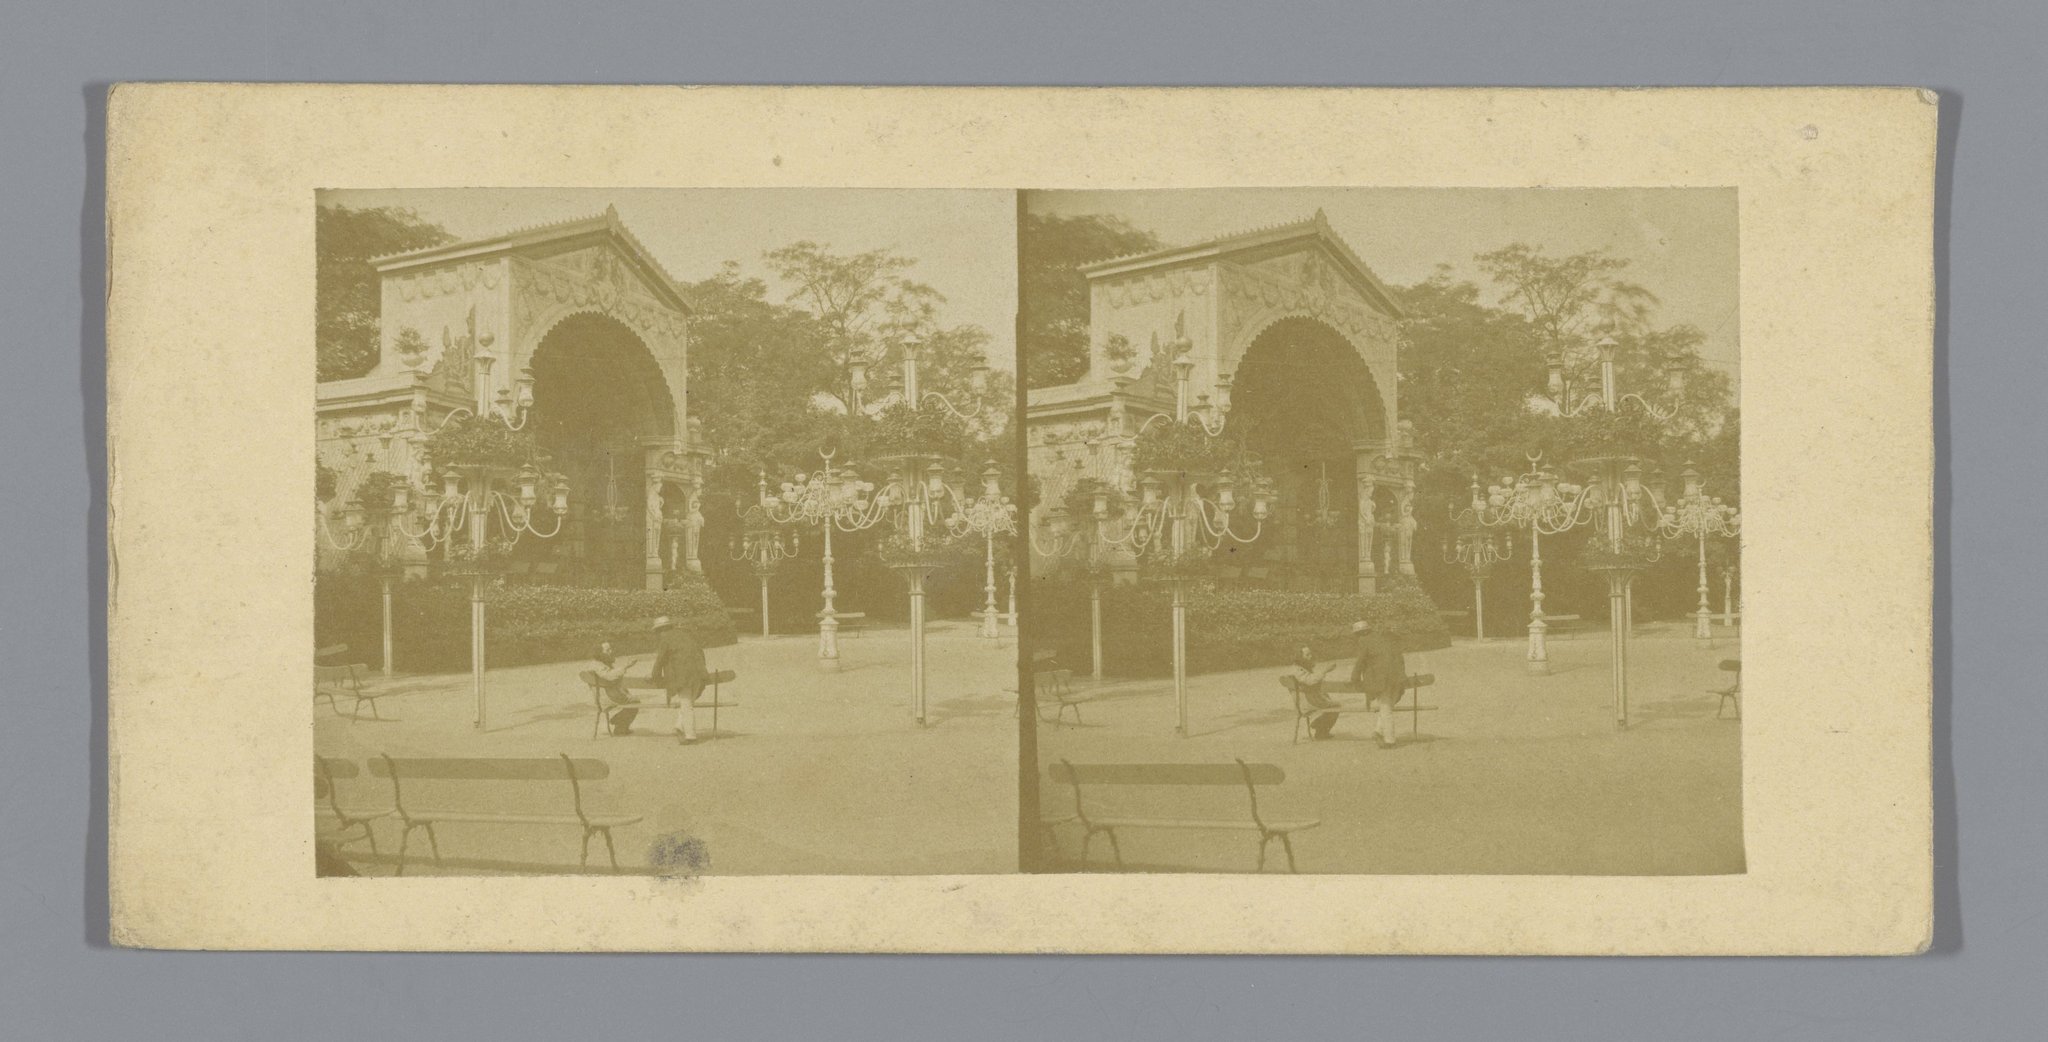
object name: stereograph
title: Toegangspoort van het Château des Fleurs te Parijs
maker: Anonymous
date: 1860-1885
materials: cardboard, photographic support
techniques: albumen print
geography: paris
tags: ball, formal dance - aa - in the open air, 'fête champêtre', gate, entrance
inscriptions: inscription: ‘Chateau des fleurs’